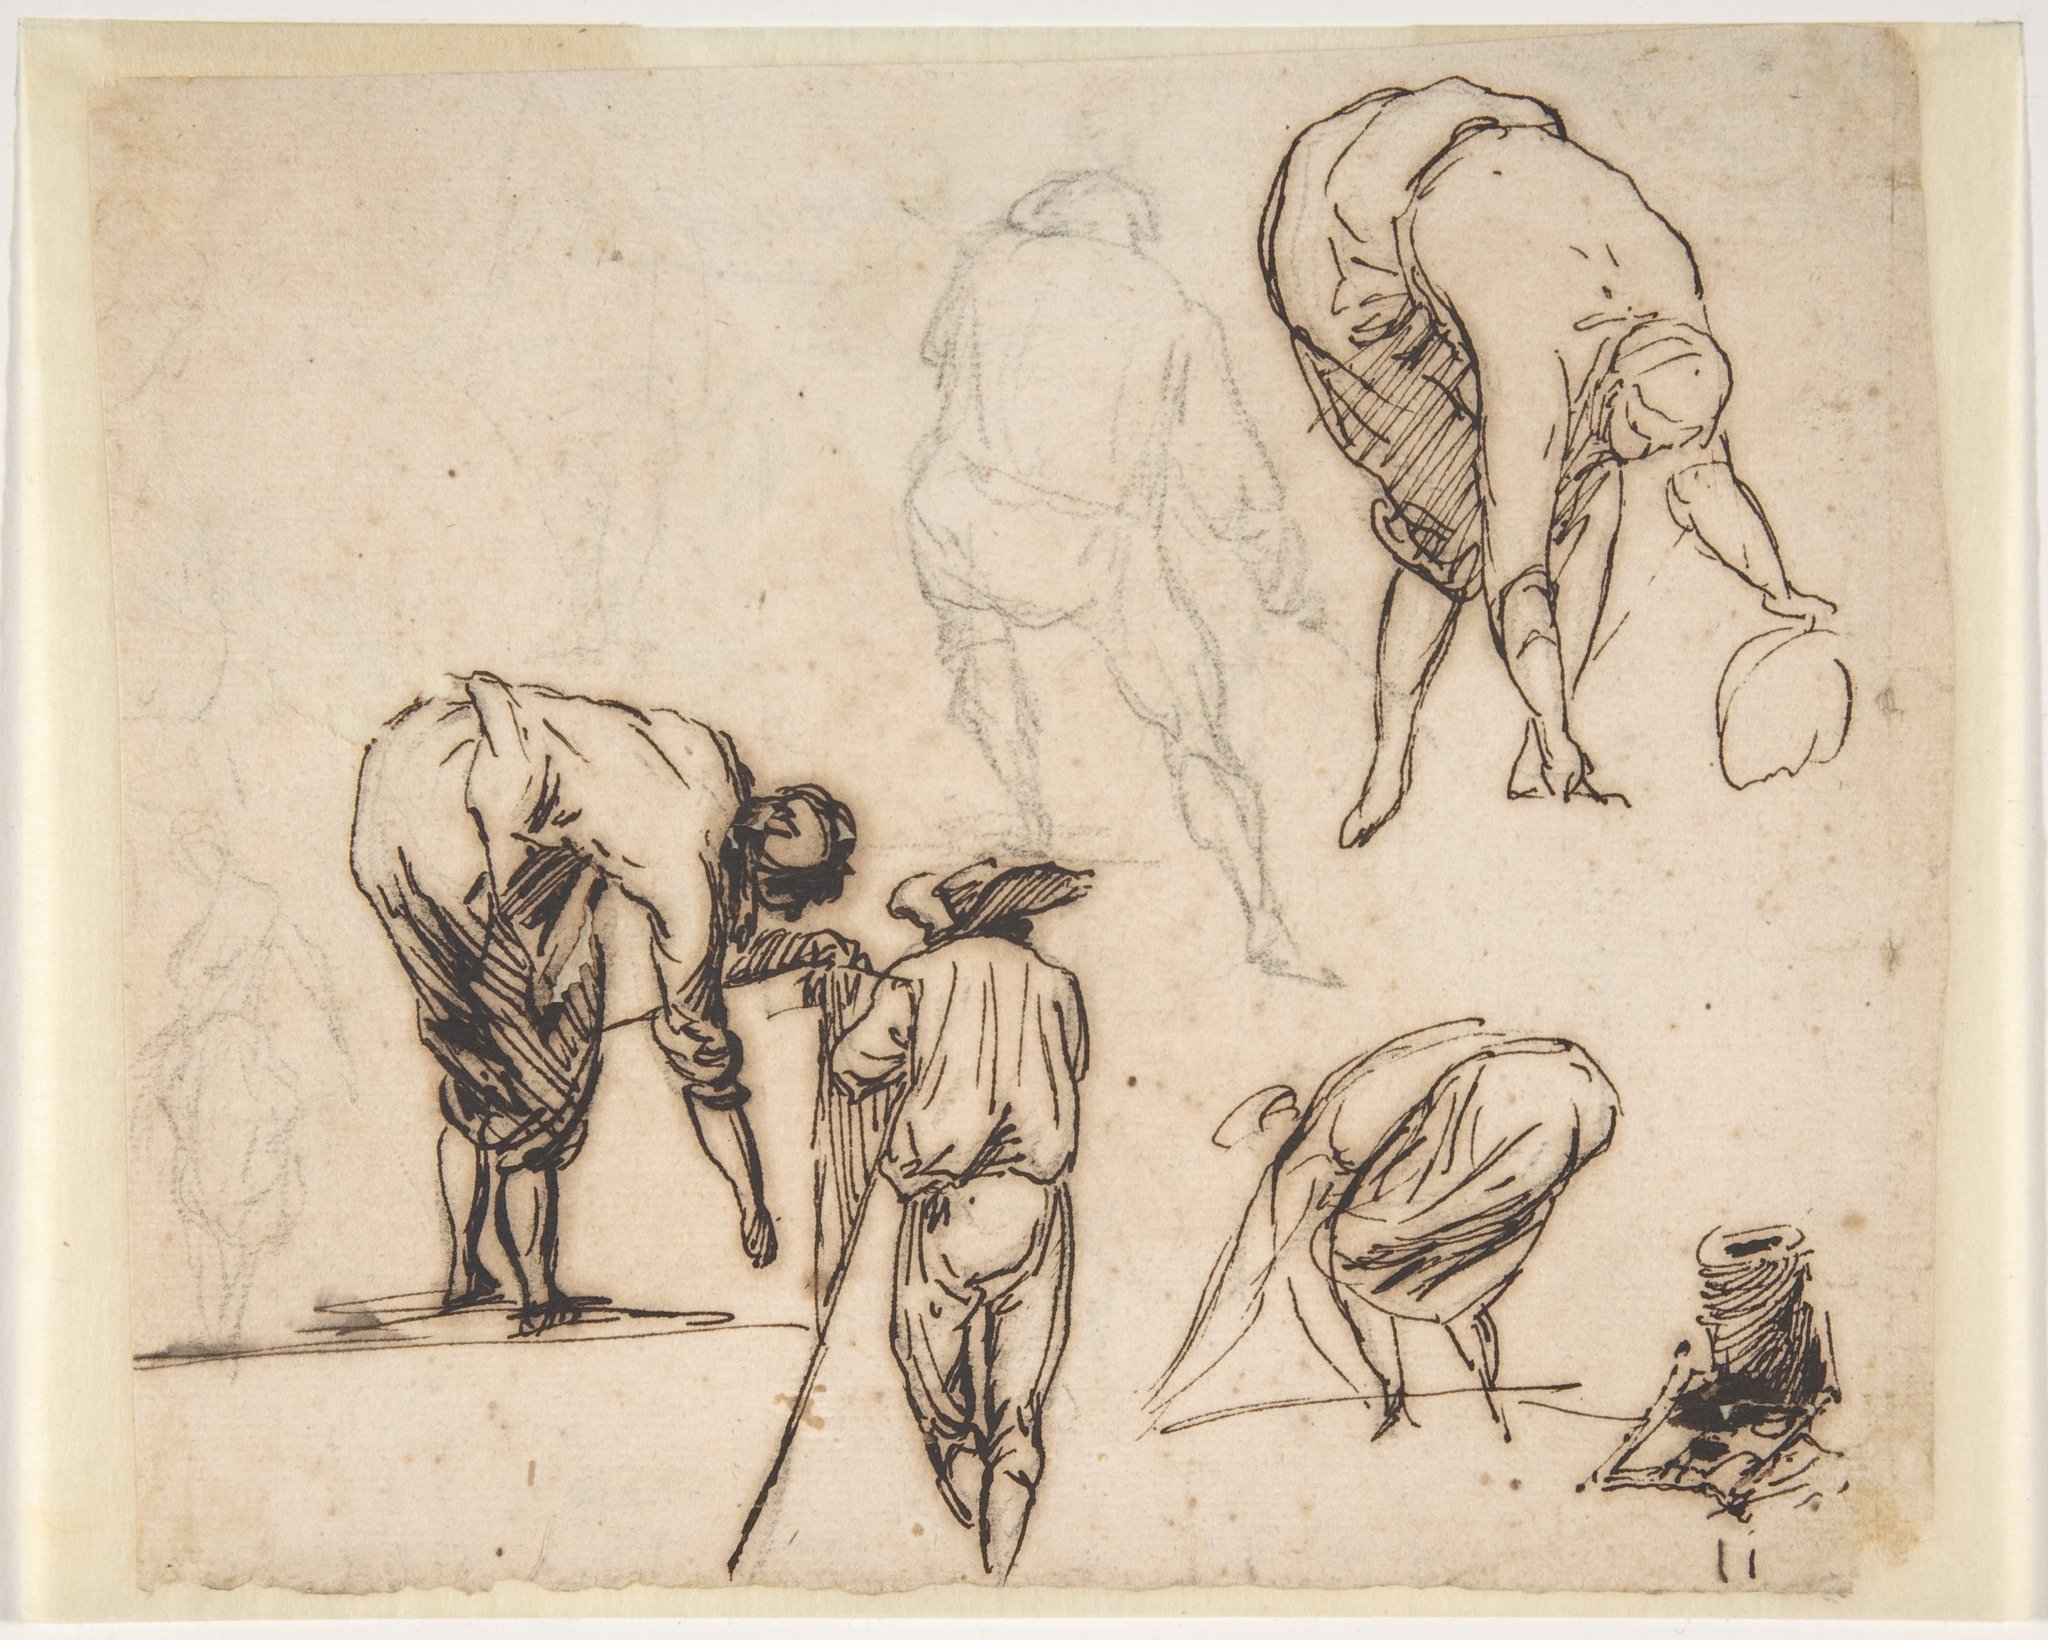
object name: drawing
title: Standing Figure and Figures Bending Over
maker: micco spadaro (domenico gargiulo)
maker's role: artist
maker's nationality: italian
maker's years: 1609-1675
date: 1612-1675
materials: chalk, ink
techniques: pen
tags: human figures,working